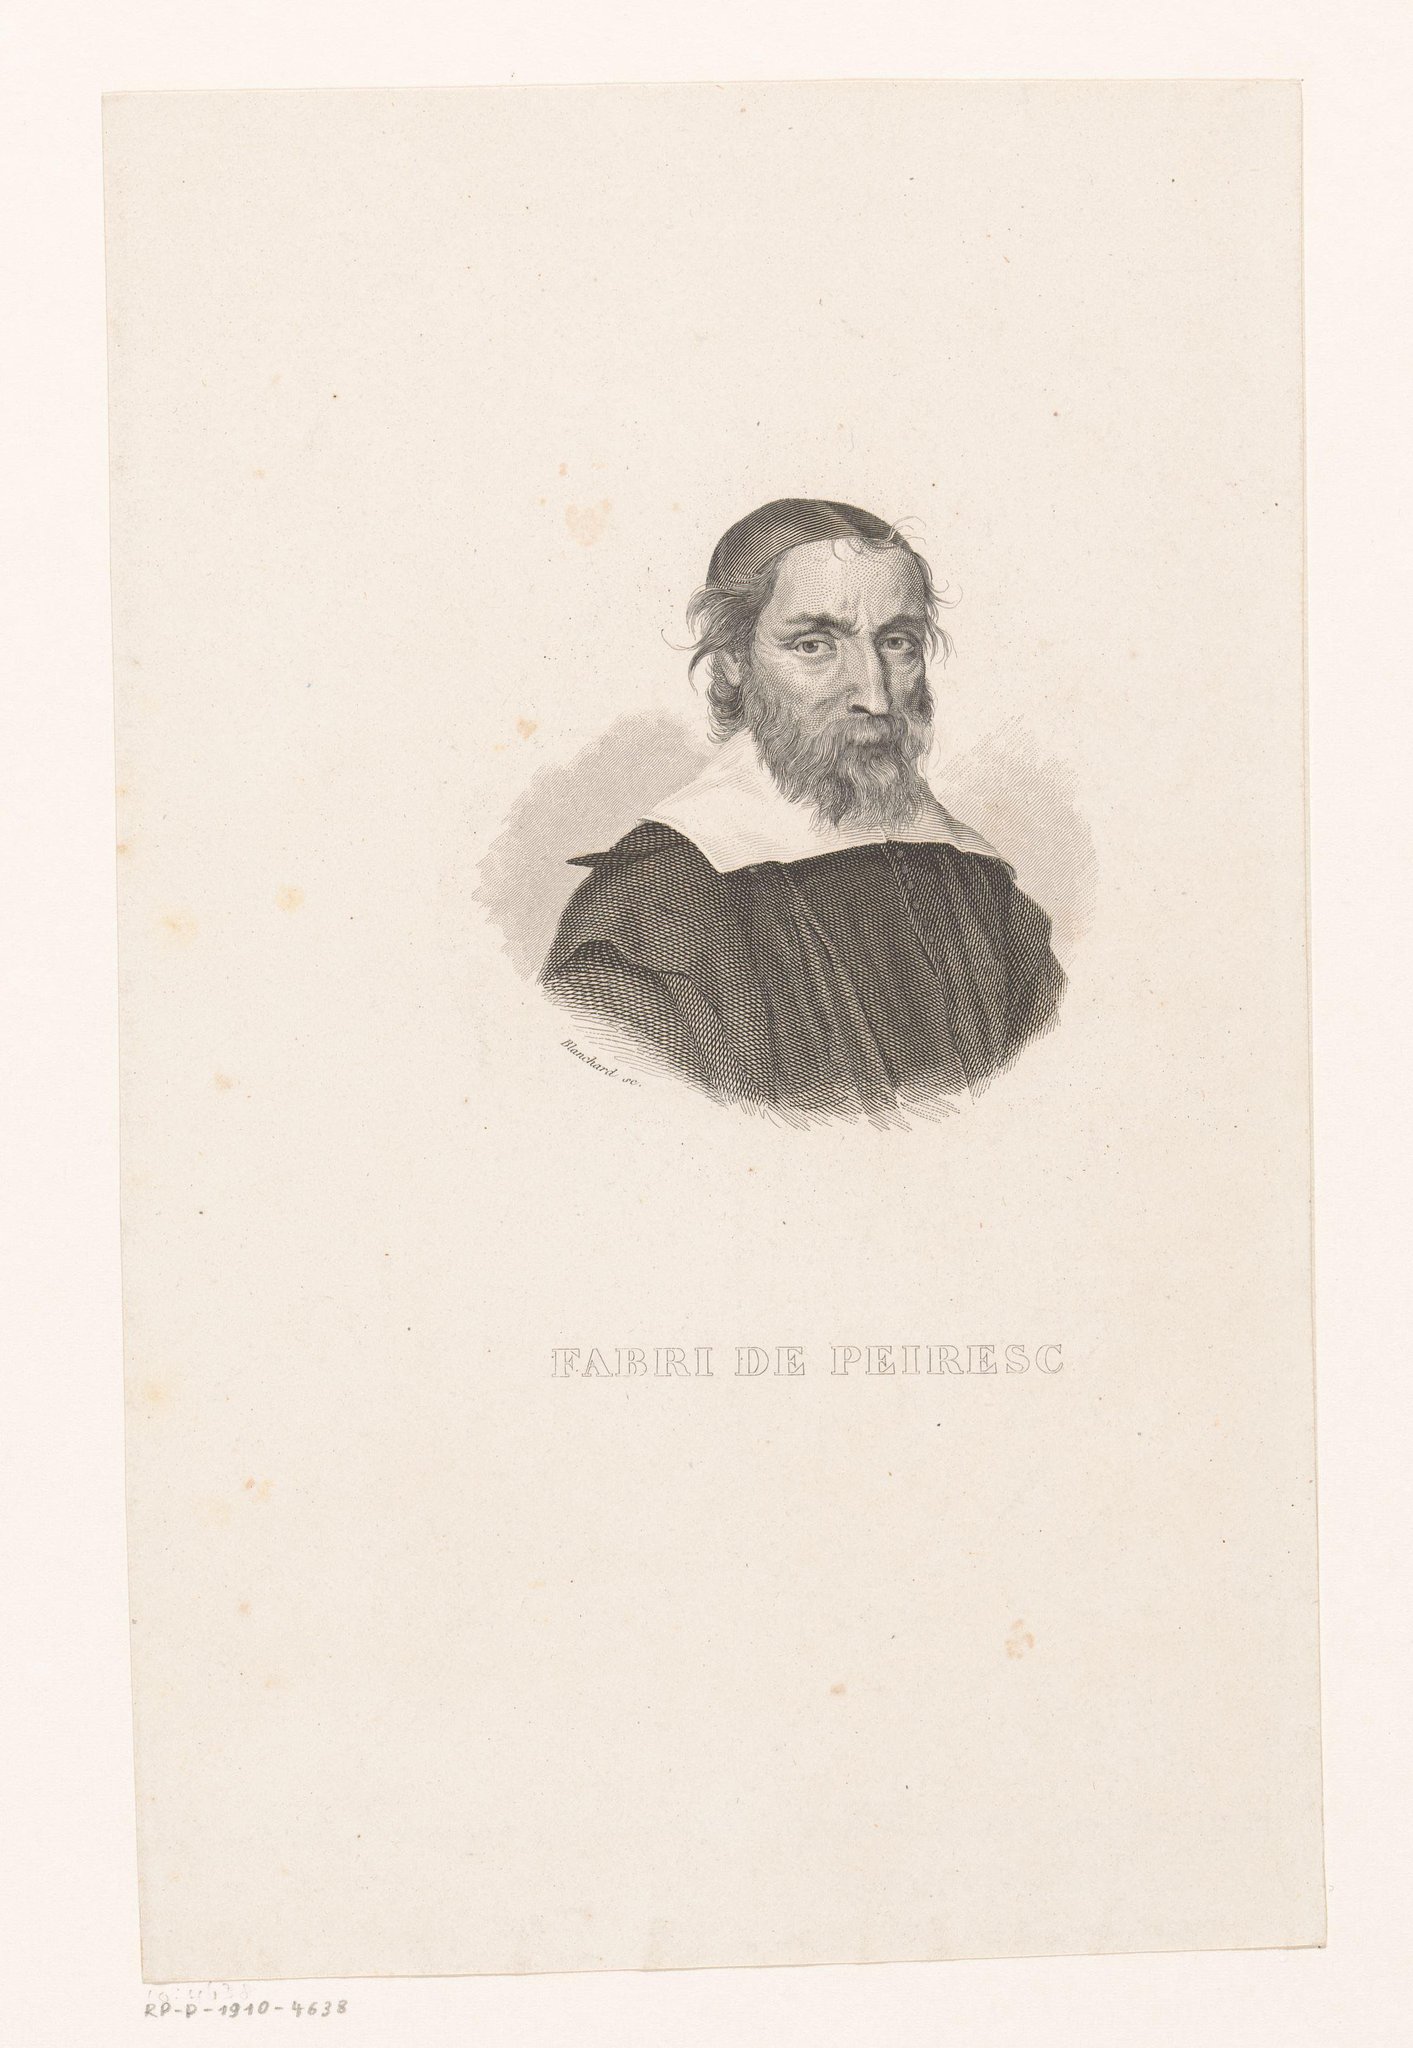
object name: print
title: Portret van Nicolas-Claude Fabri de Peiresc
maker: auguste thomas marie blanchard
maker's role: print maker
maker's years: 1819-1898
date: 1829-1898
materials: paper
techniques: engraving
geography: france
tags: nicolas-claude fabri de peiresc, historical persons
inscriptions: collector's mark: Lugt 2228